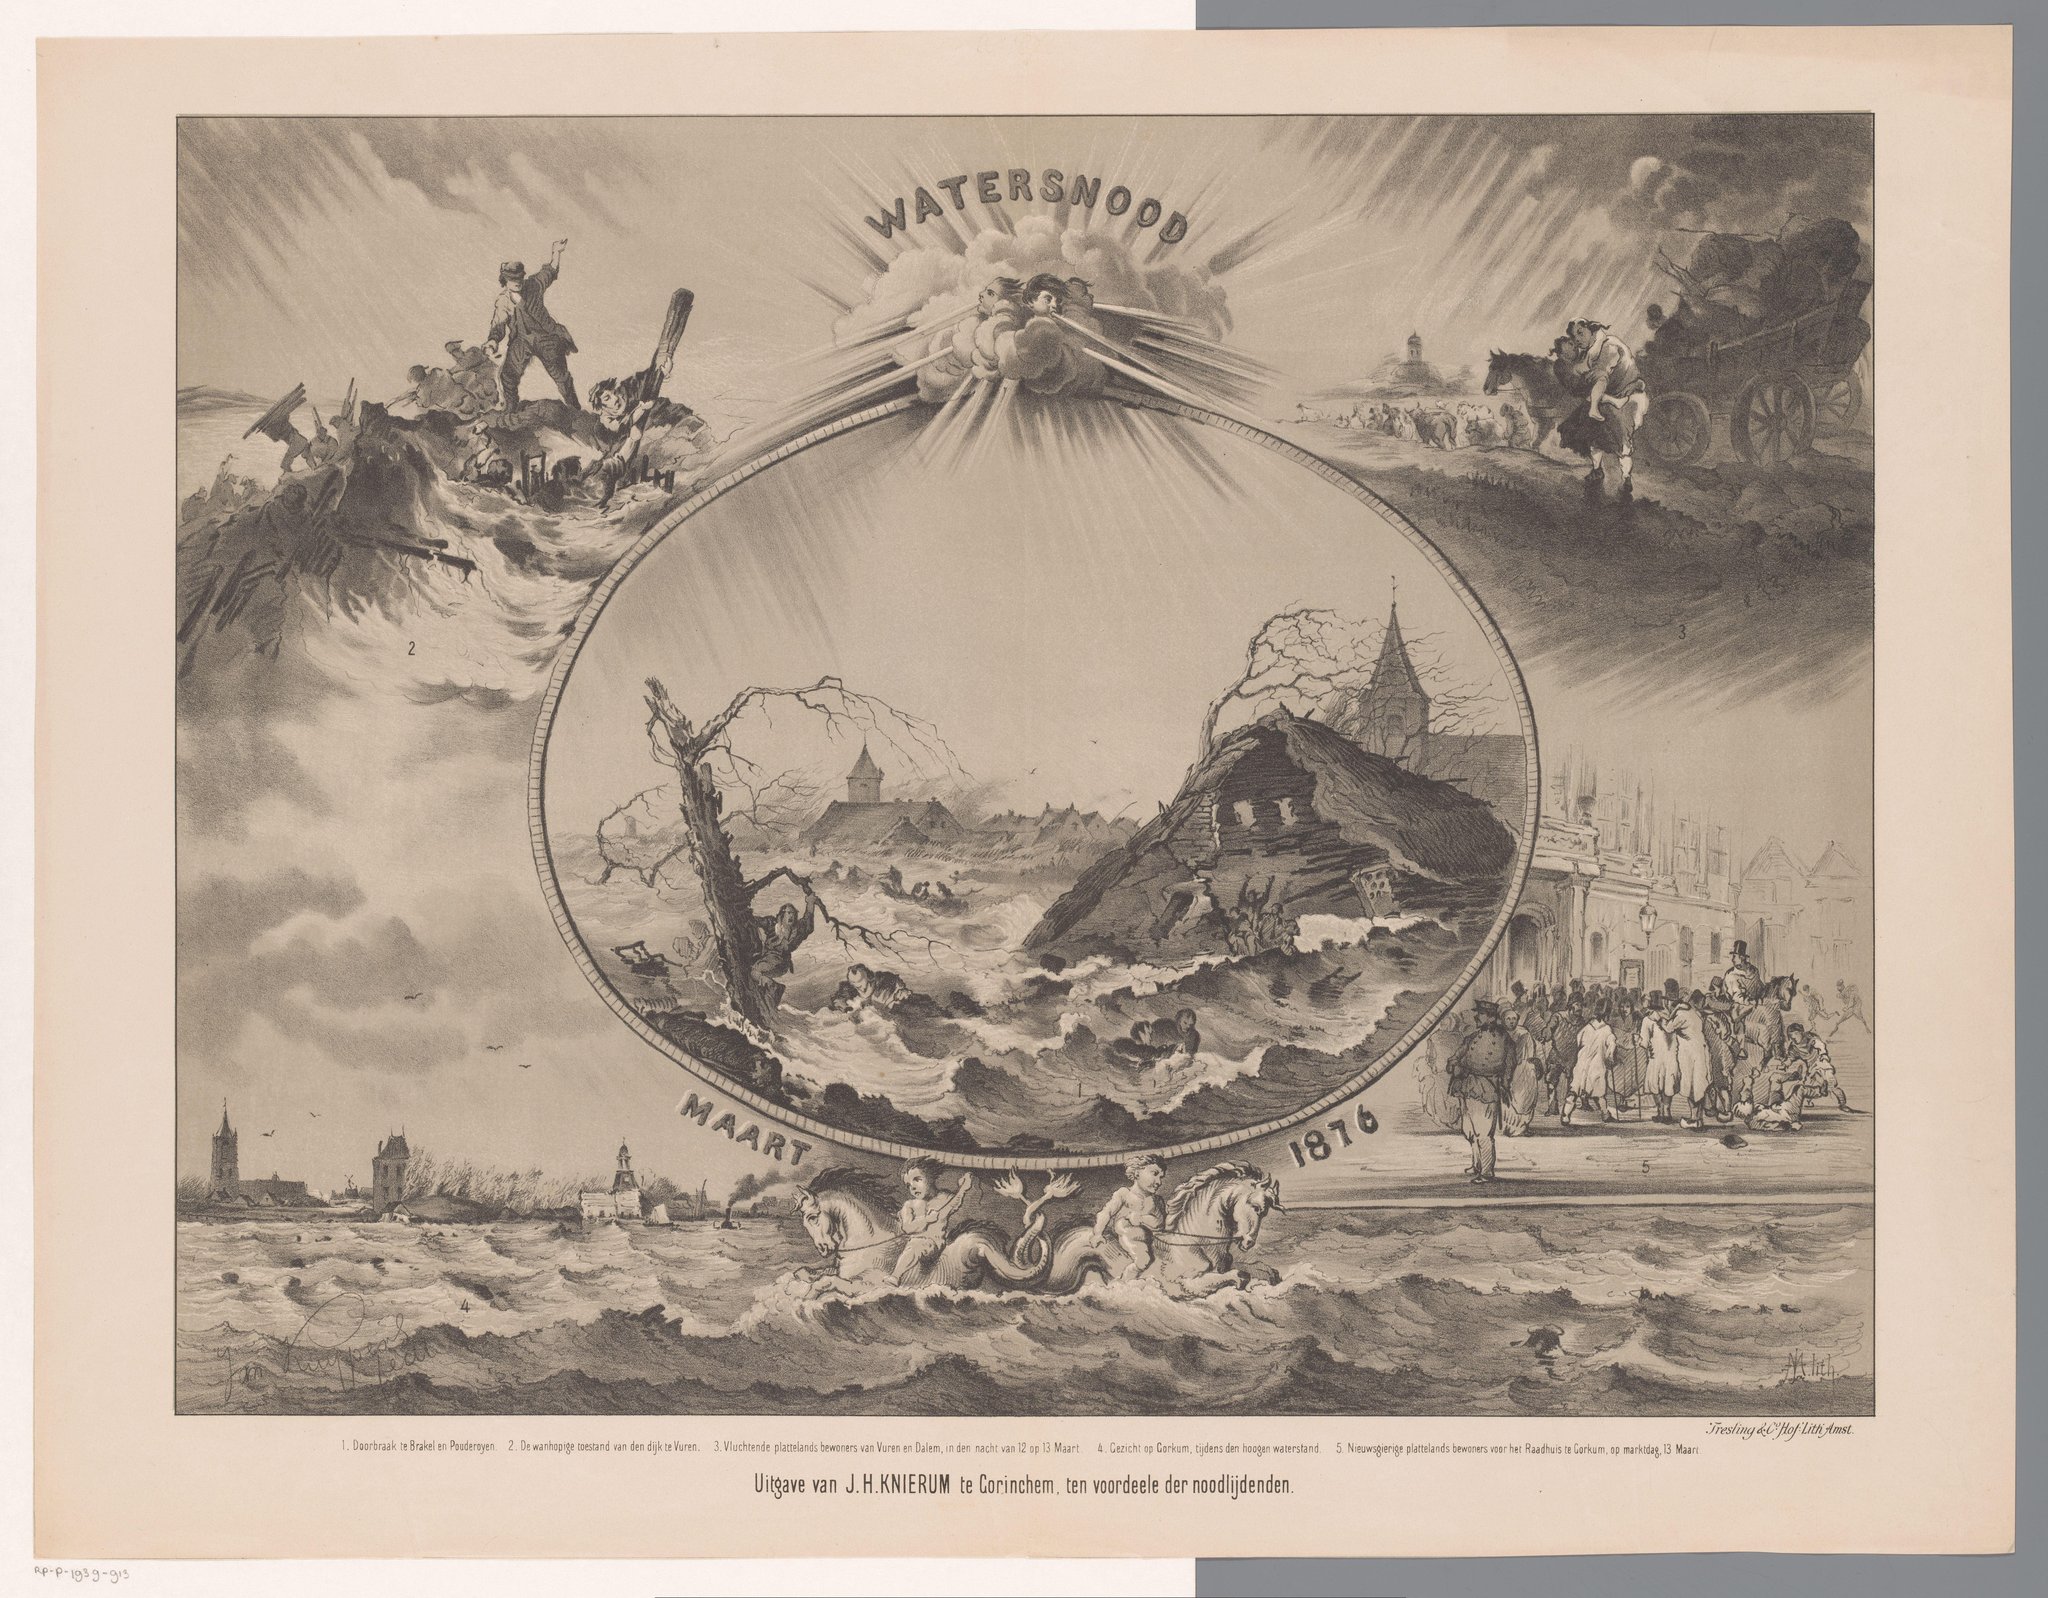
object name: print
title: Watersnoodramp van maart 1876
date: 1876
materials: paper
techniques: lithograph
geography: gorinchem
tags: rescue work during a flood, flood, dike-break (+ landscape with figures, staffage)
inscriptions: collector's mark: Lugt 2228, collector's mark: Lugt 2760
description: De voorstellingen zijn voorzien van een nummer overeenkomstig de legenda onder de afbeelding. In het midden worden twee dorpen, Brakel en Pouderoyen, door golven zo hoog als de daken weggevaagd. Mensen worden meegesleurd. Linksboven werken mannen aan het verstevigen van een dijk te Vuren. Rechts vluchtende bewoners van Vuren en Dalem in de nacht van 12 op 13 maart. In de voorgrond omhelst een moeder haar kind. Rechtsonder hebben plattelandsbewoners zich verzameld voor het raadhuis te Gorinchem. Onderin een gezicht op Gorinchem tijdens de hoge waterstand. De prent werd gemaakt om geld in te zamelen voor de getroffen bewoners van het gebied.